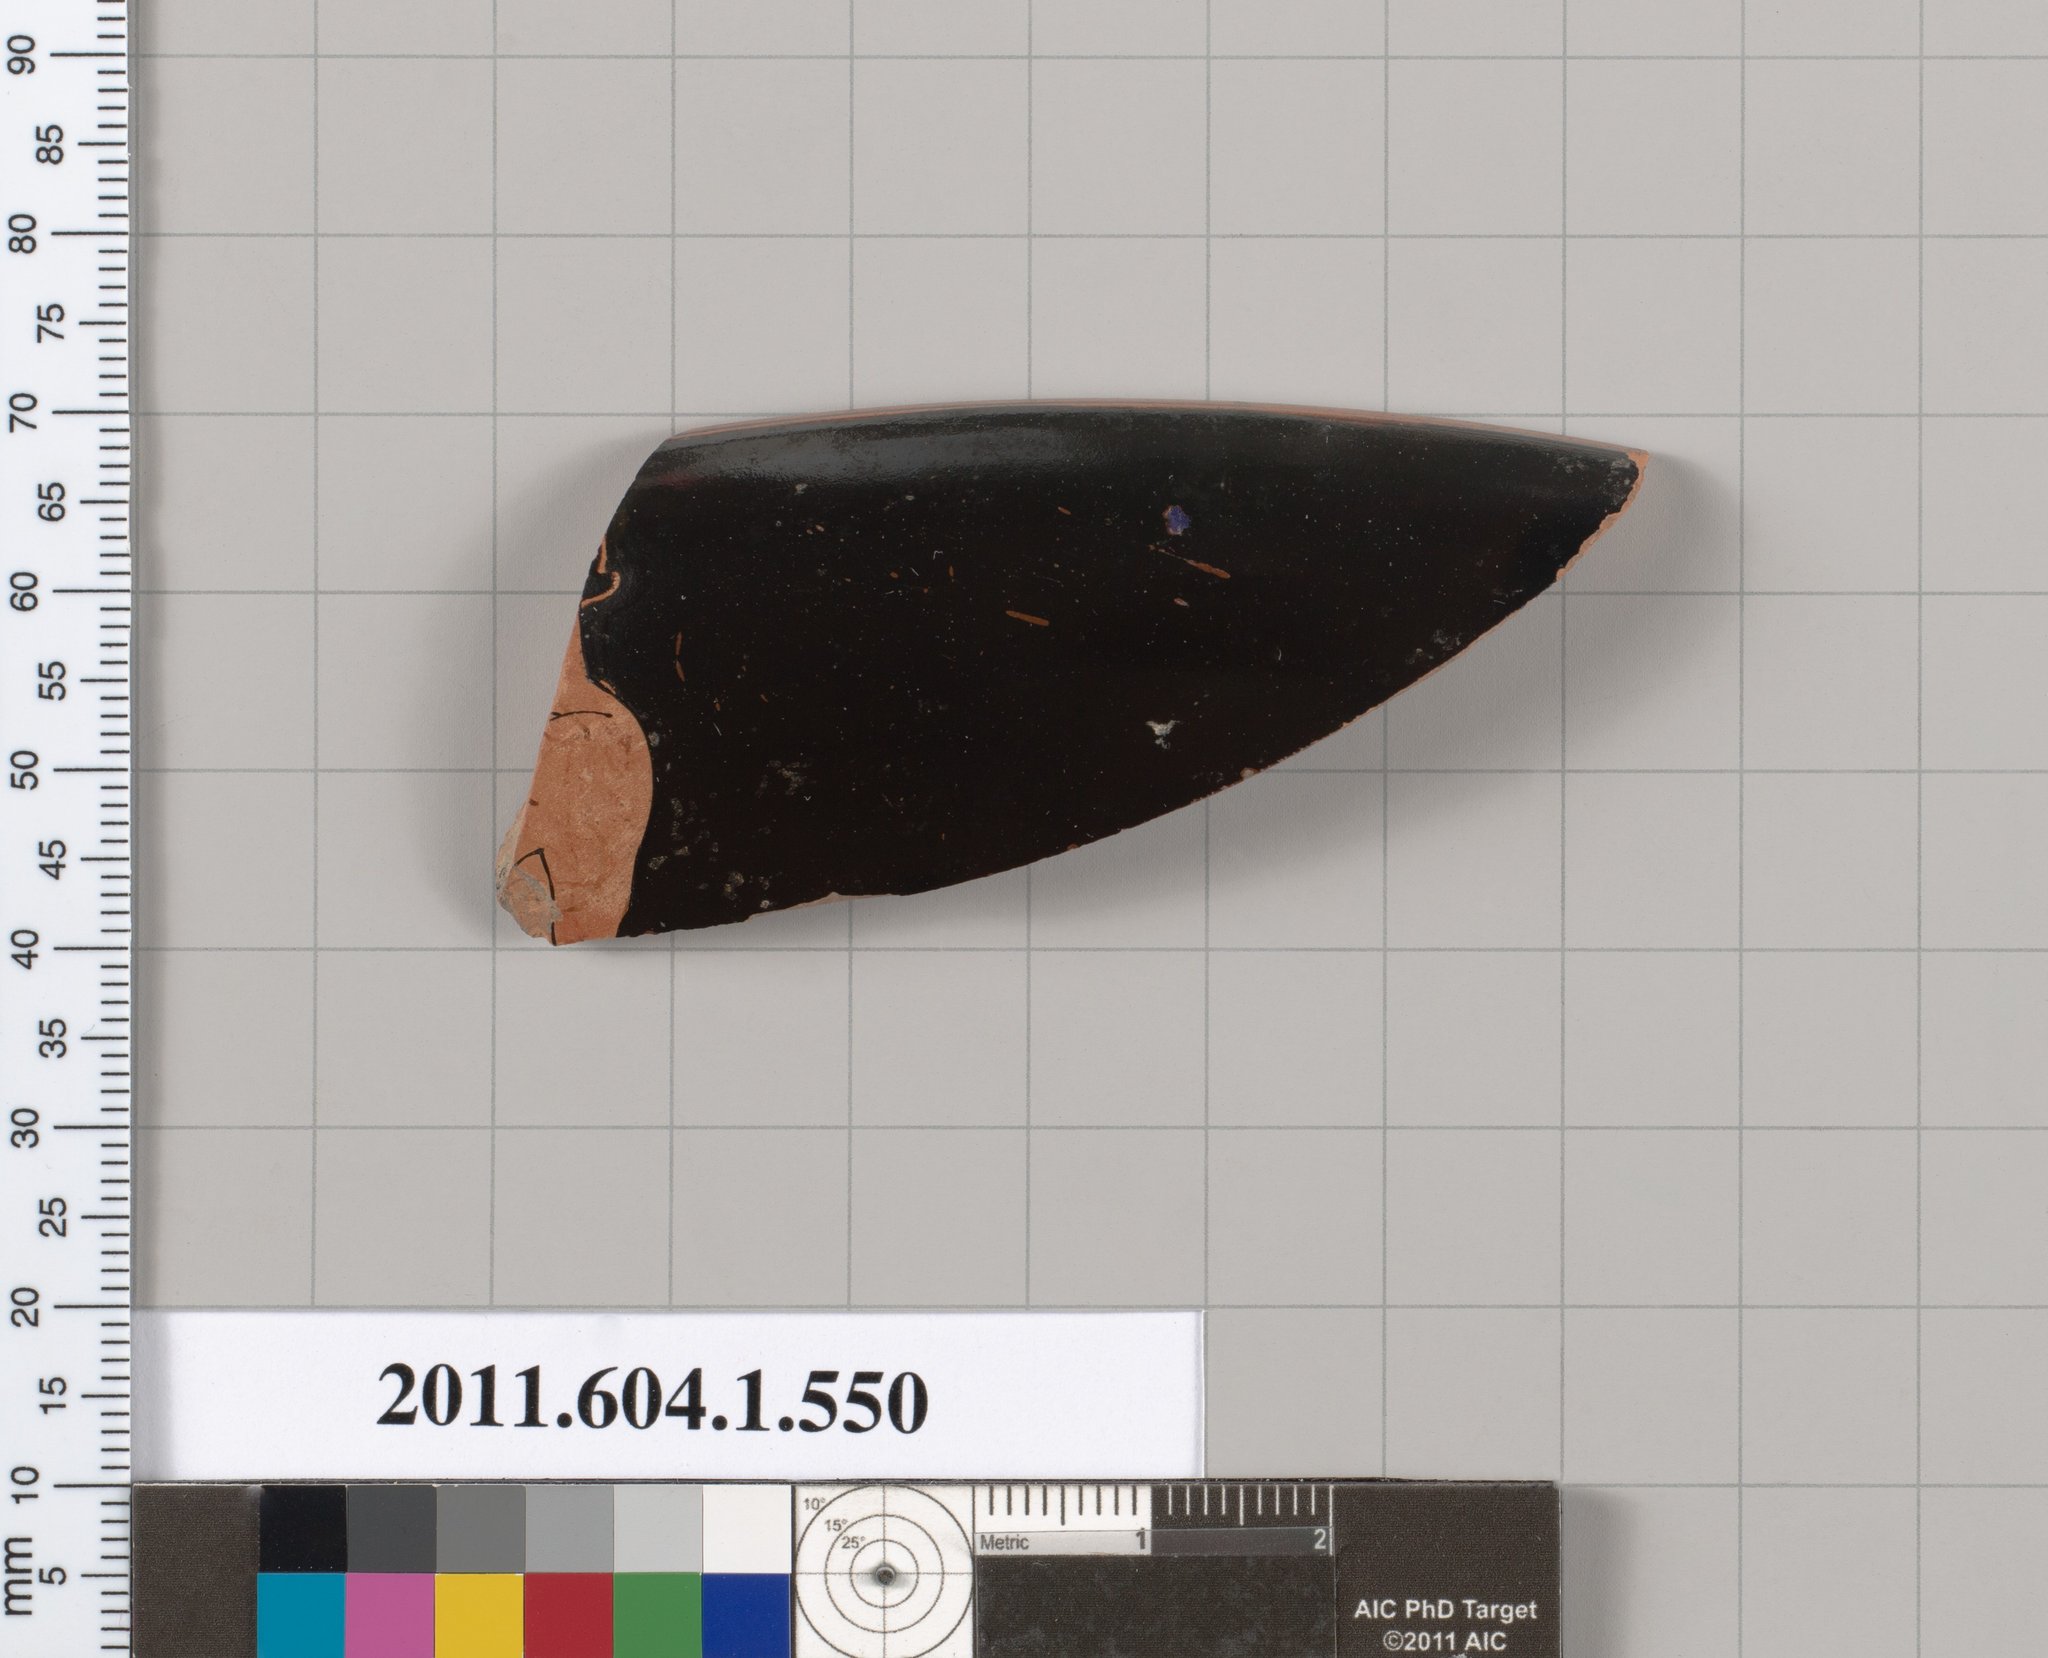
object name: kylix fragment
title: Terracotta rim fragment of a kylix (drinking cup)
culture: greek, attic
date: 480-470 BCE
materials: terracotta